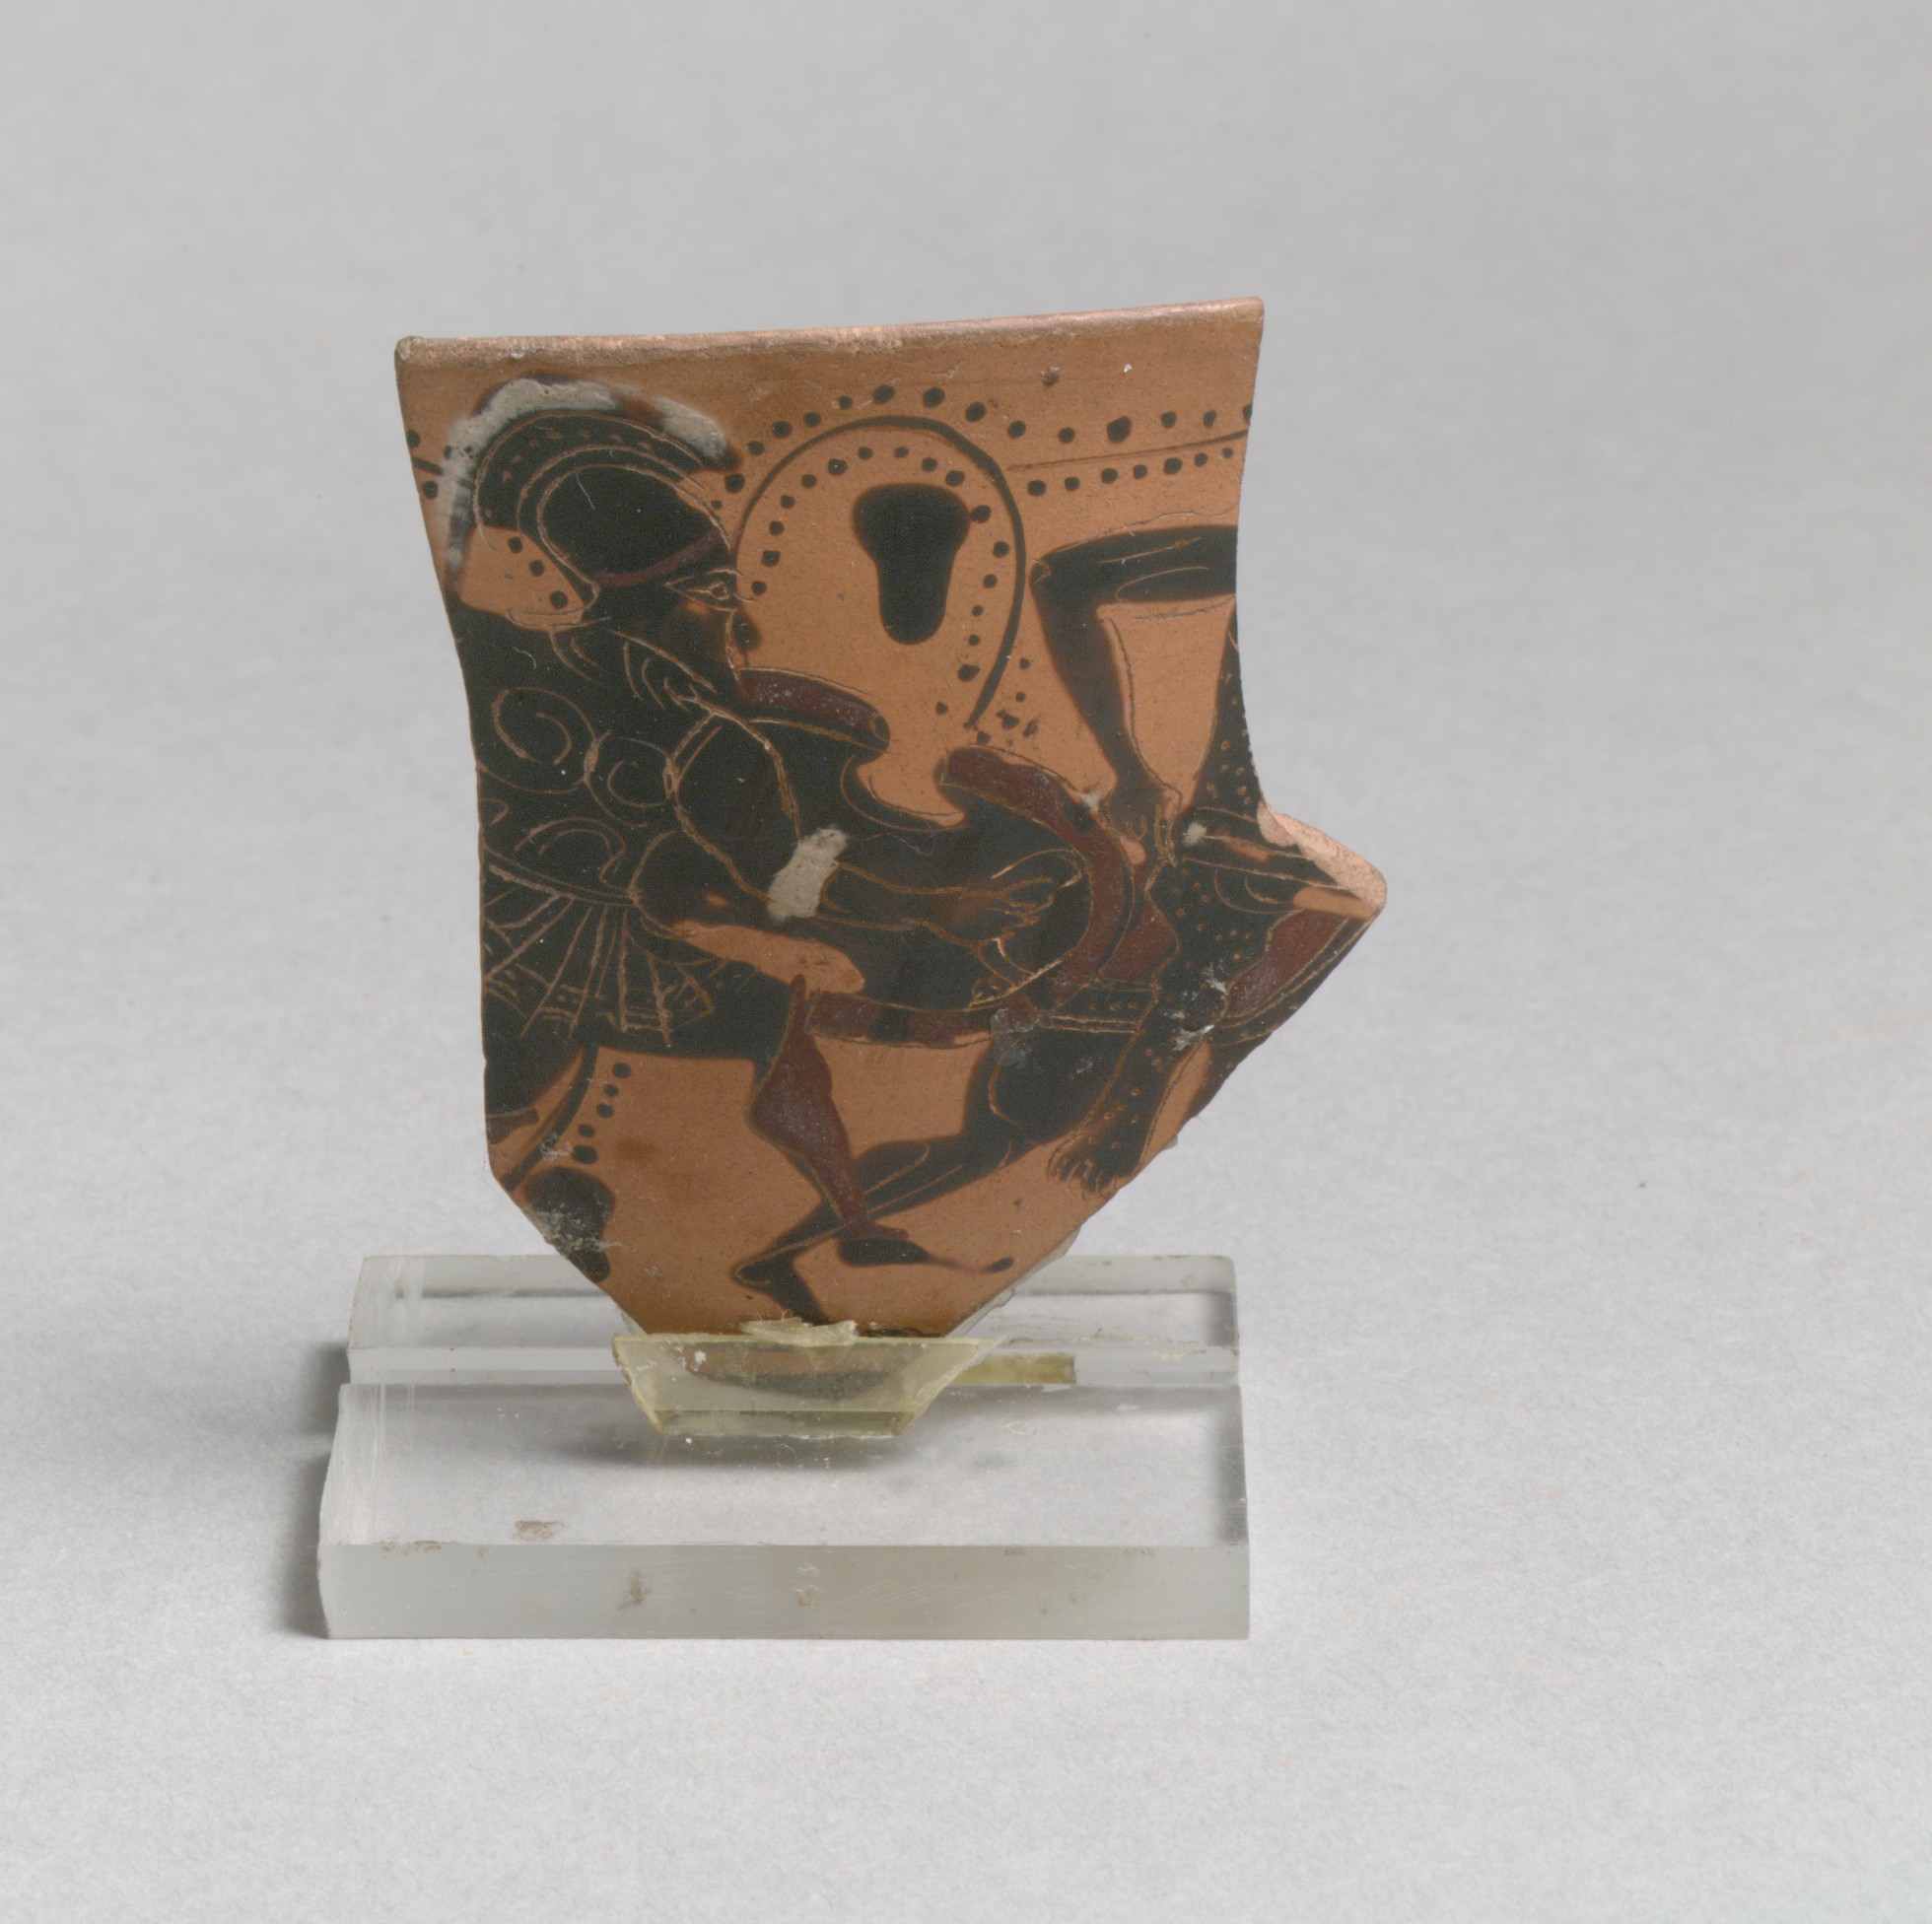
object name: kyathos fragment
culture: greek, attic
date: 525-500 BCE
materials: terracotta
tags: helmets,shields,men